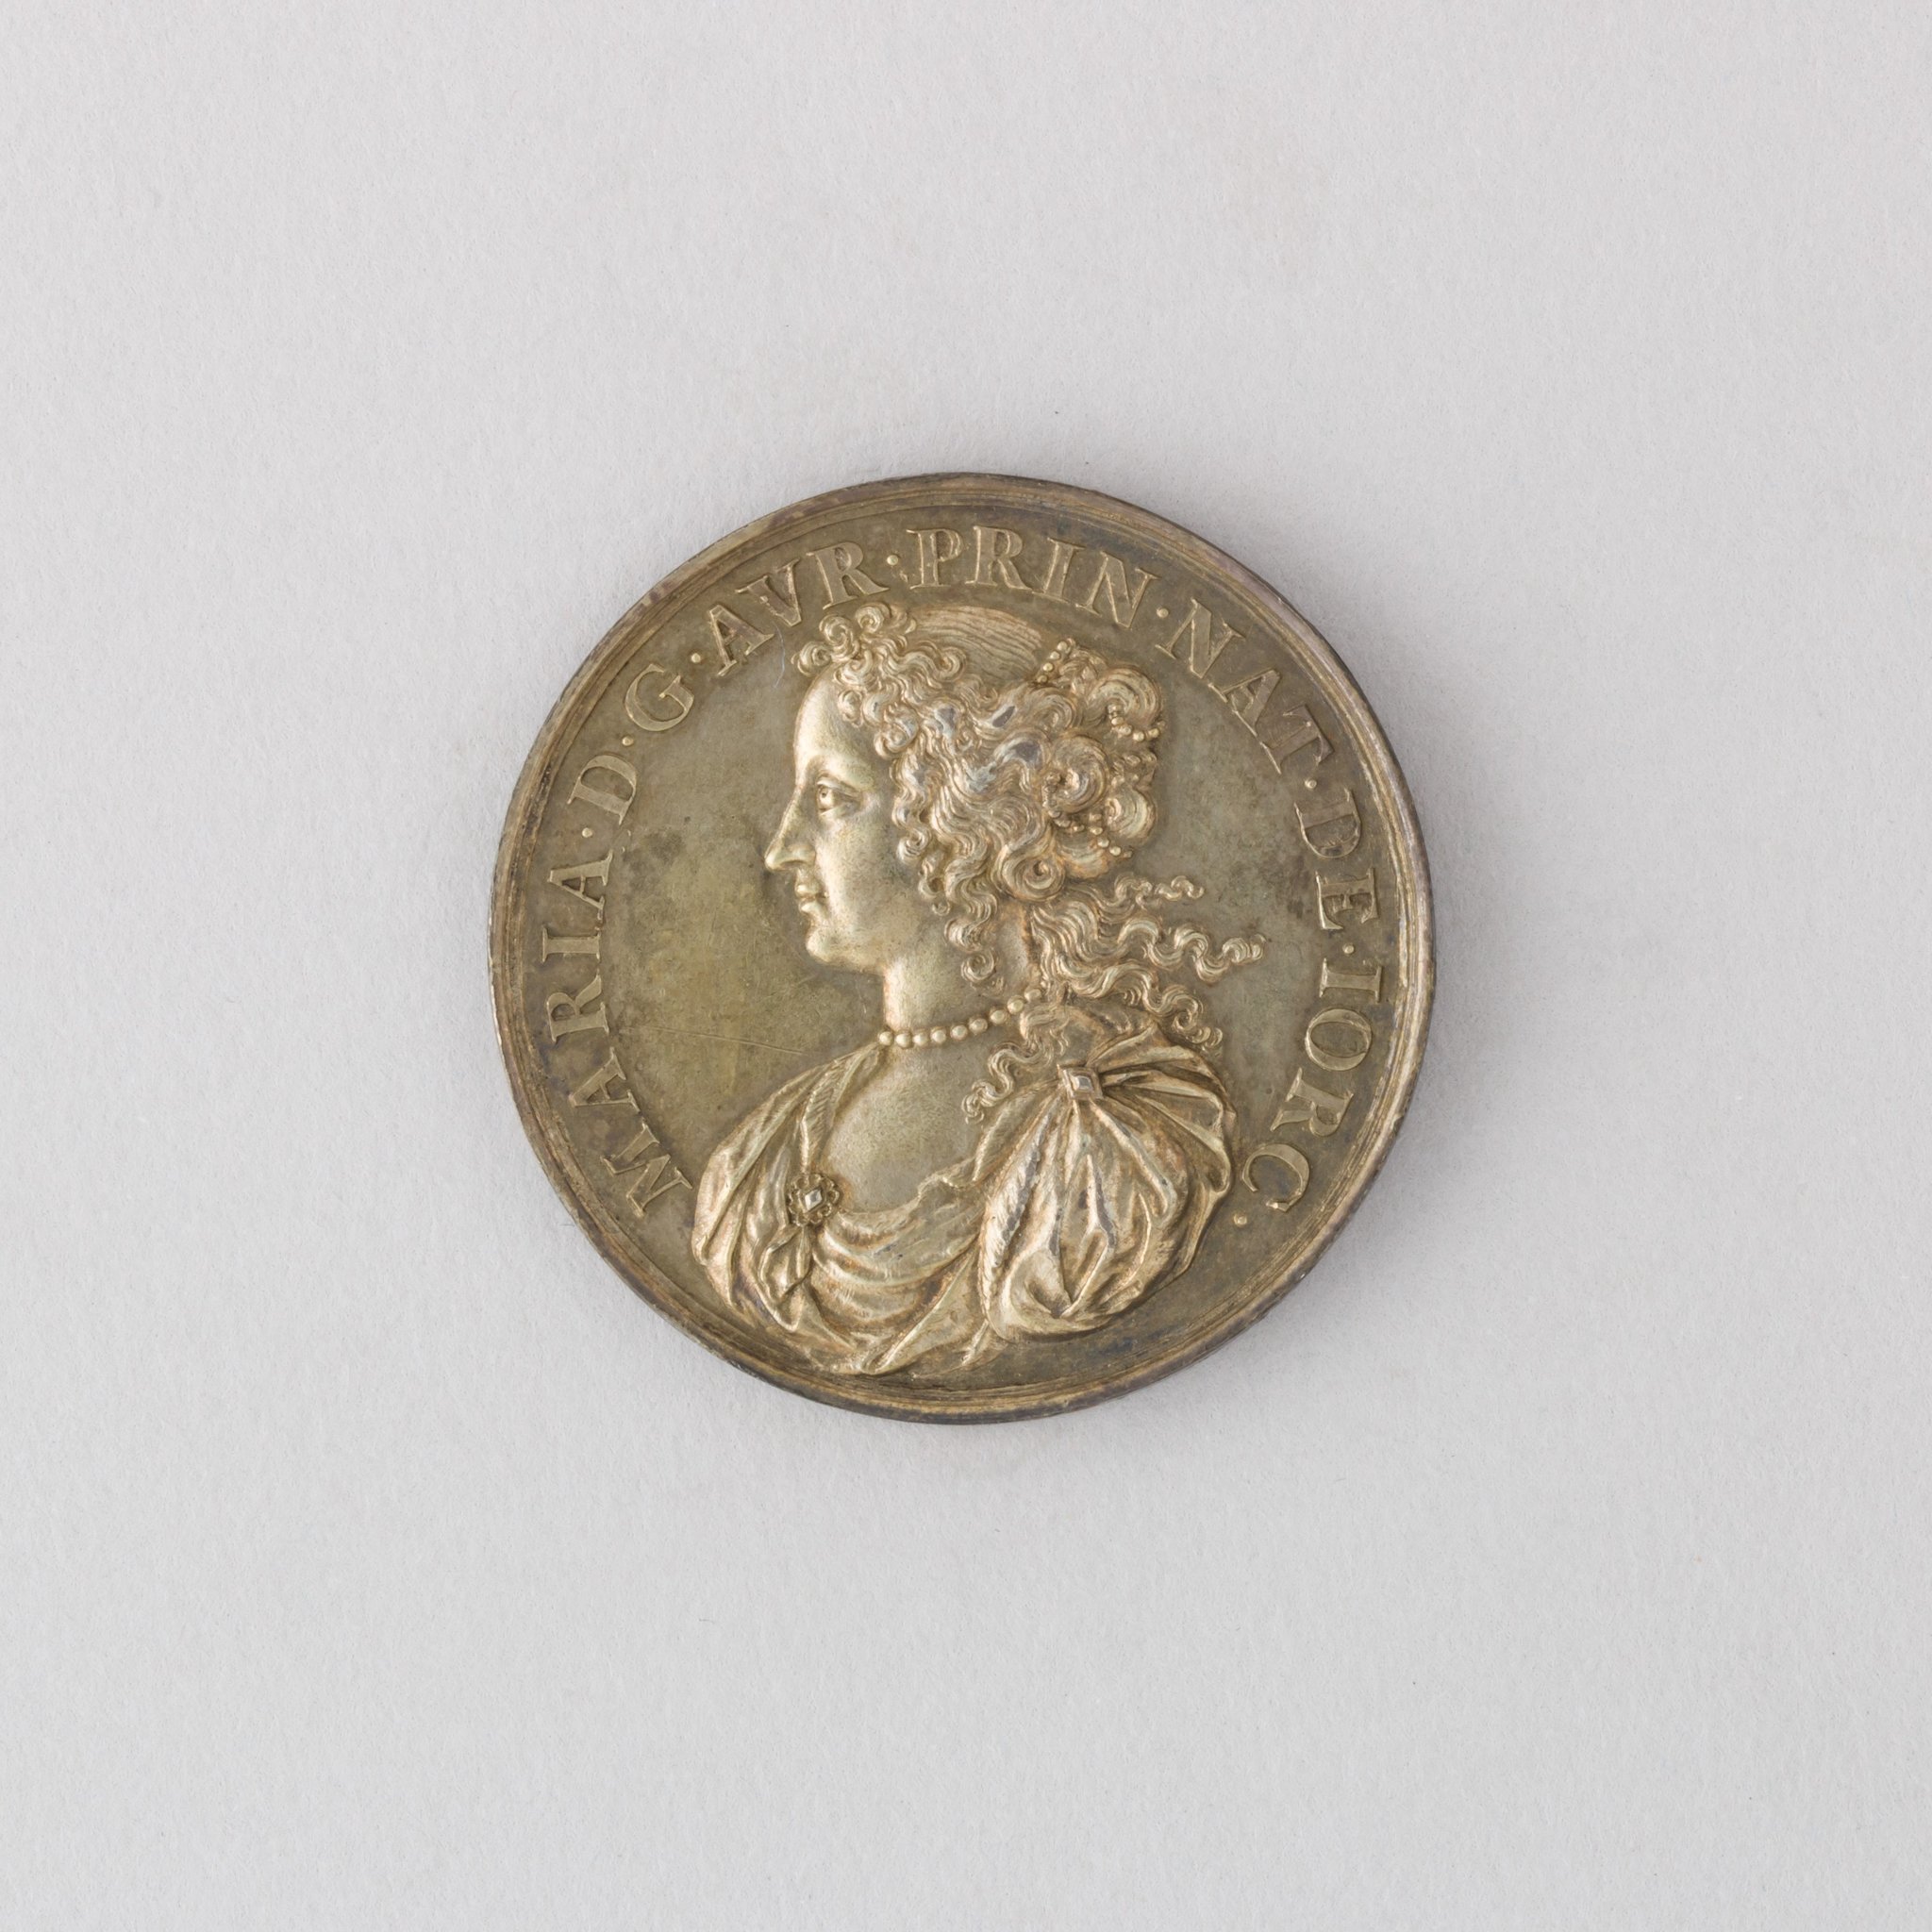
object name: medal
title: Medal Commemorating the Marriage of William III, Prince of Orange and Princess Mary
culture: dutch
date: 1677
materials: gold, silver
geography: netherlands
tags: princesses,profiles,women